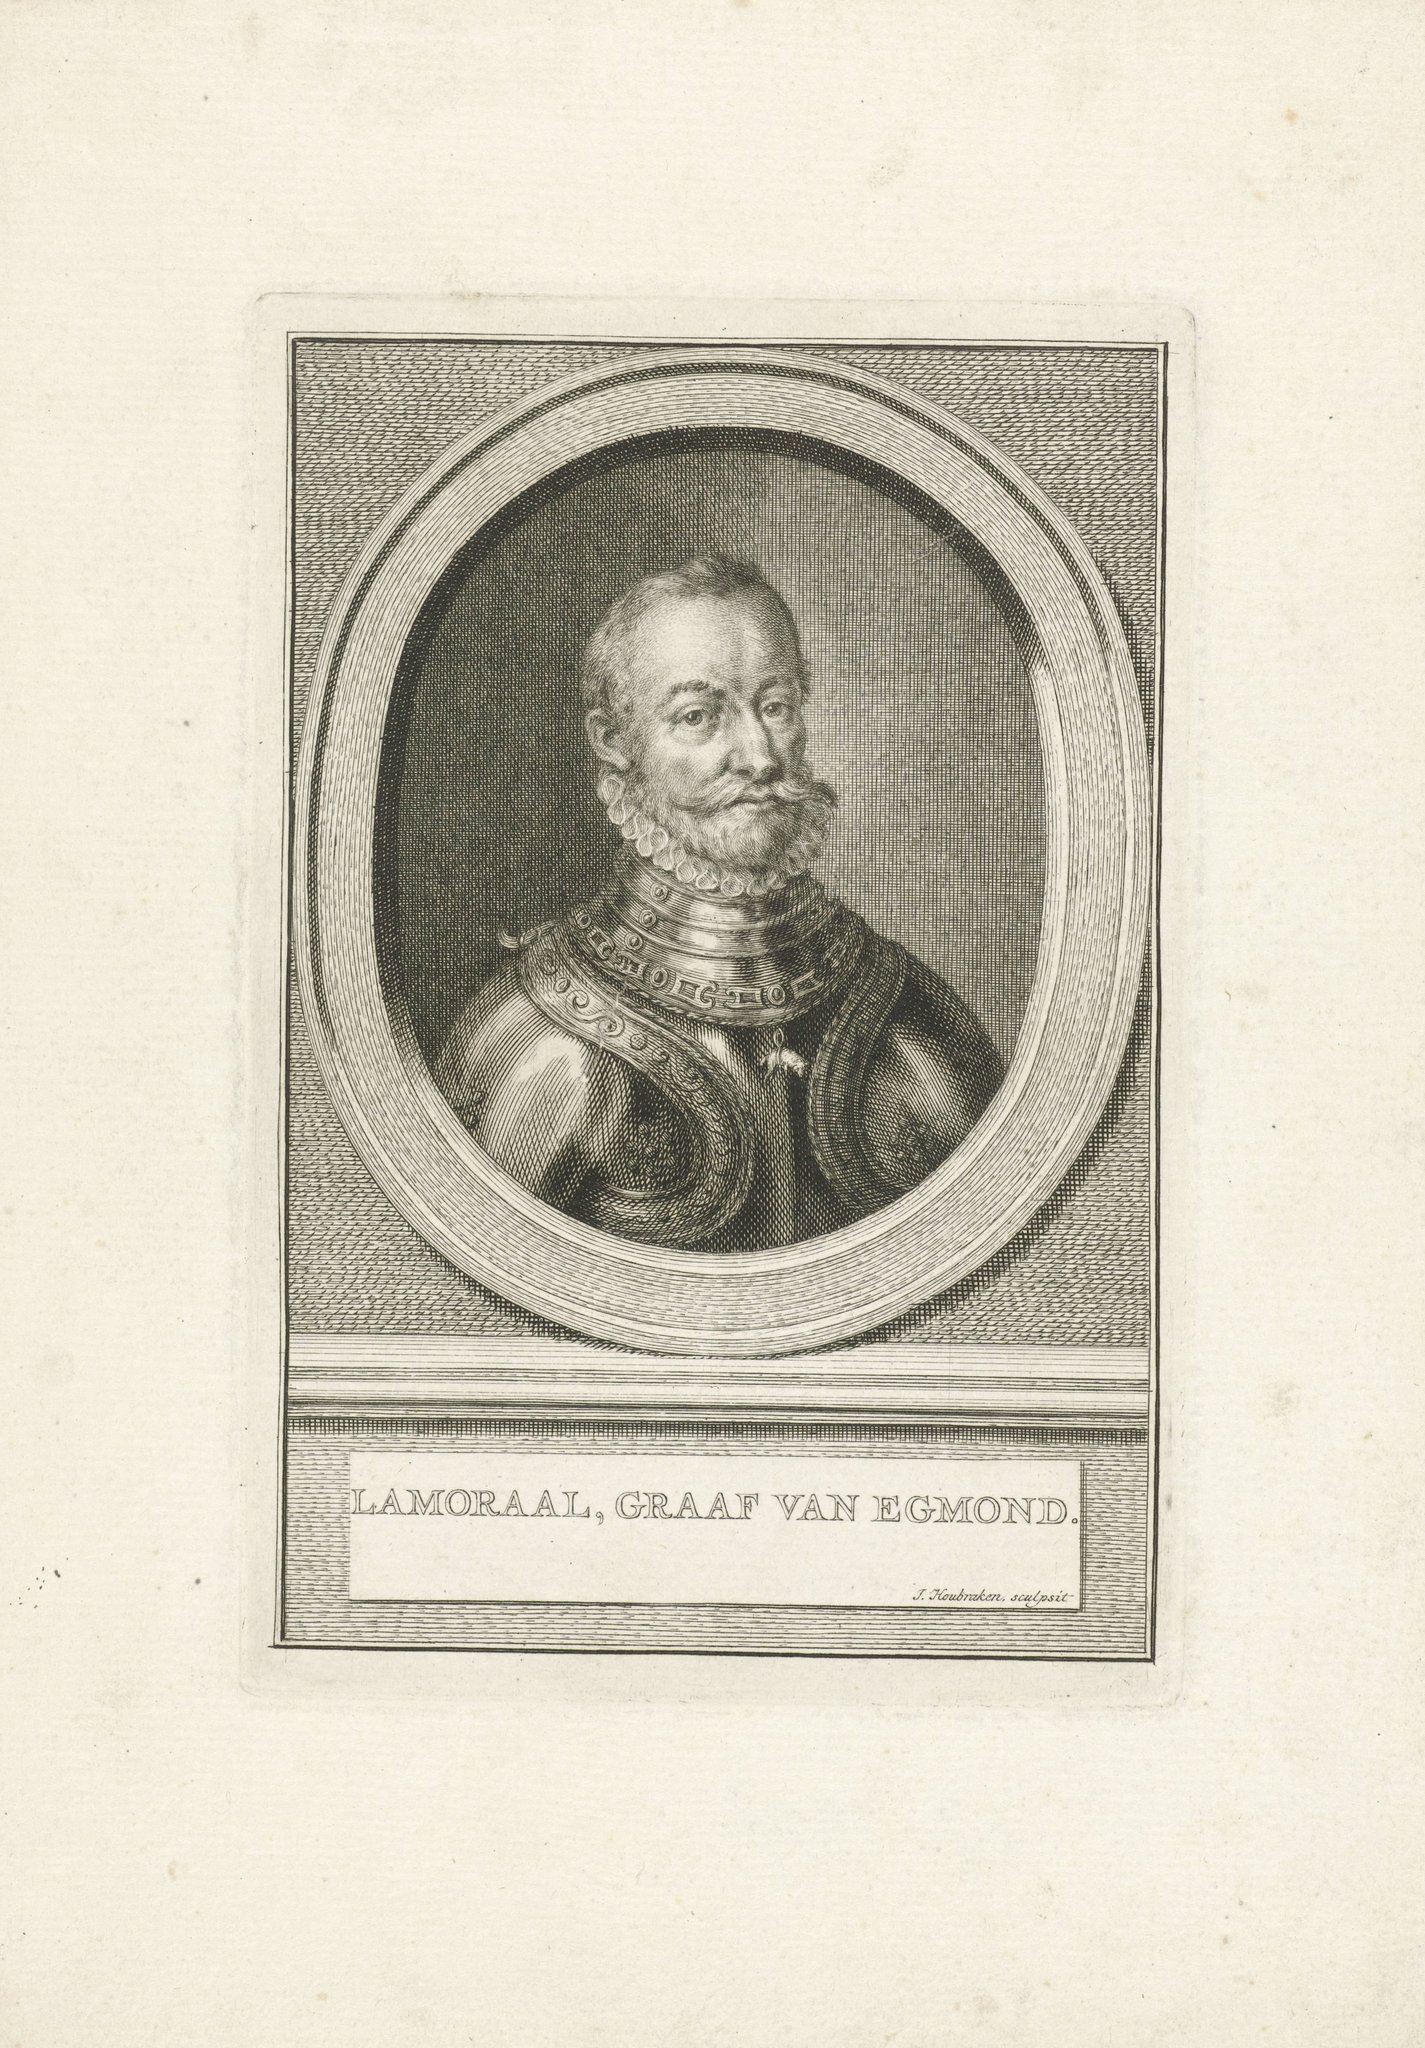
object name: print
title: Portret van Lamoraal, graaf van Egmond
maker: jacob houbraken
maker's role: draughtsman, print maker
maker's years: 1698-1780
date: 1749-1759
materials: paper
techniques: engraving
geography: amsterdam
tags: brussels, earl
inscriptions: collector's mark: Lugt 2228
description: Prent oorspronkelijk bedoeld voor: Jan Wagenaar, Vaderlandsche historie, vervattende de geschiedenissen der nu Vereenigde Nederlanden, inzonderheid die van Holland (...), 21 delen. Amsterdam, Isaak Tirion, 1749-59.